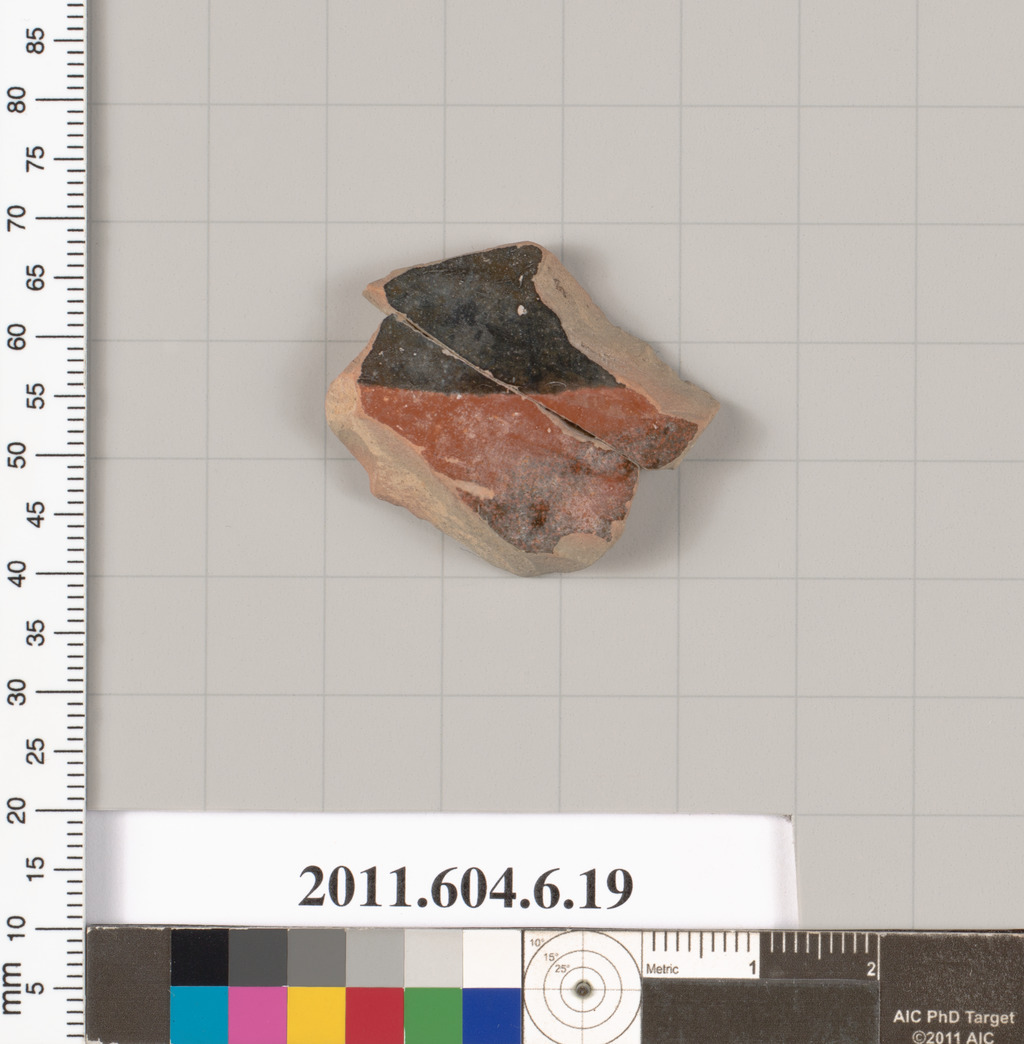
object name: undetermined open shape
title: Terracotta fragment of an open shape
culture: greek, attic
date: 600-401 BCE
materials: terracotta